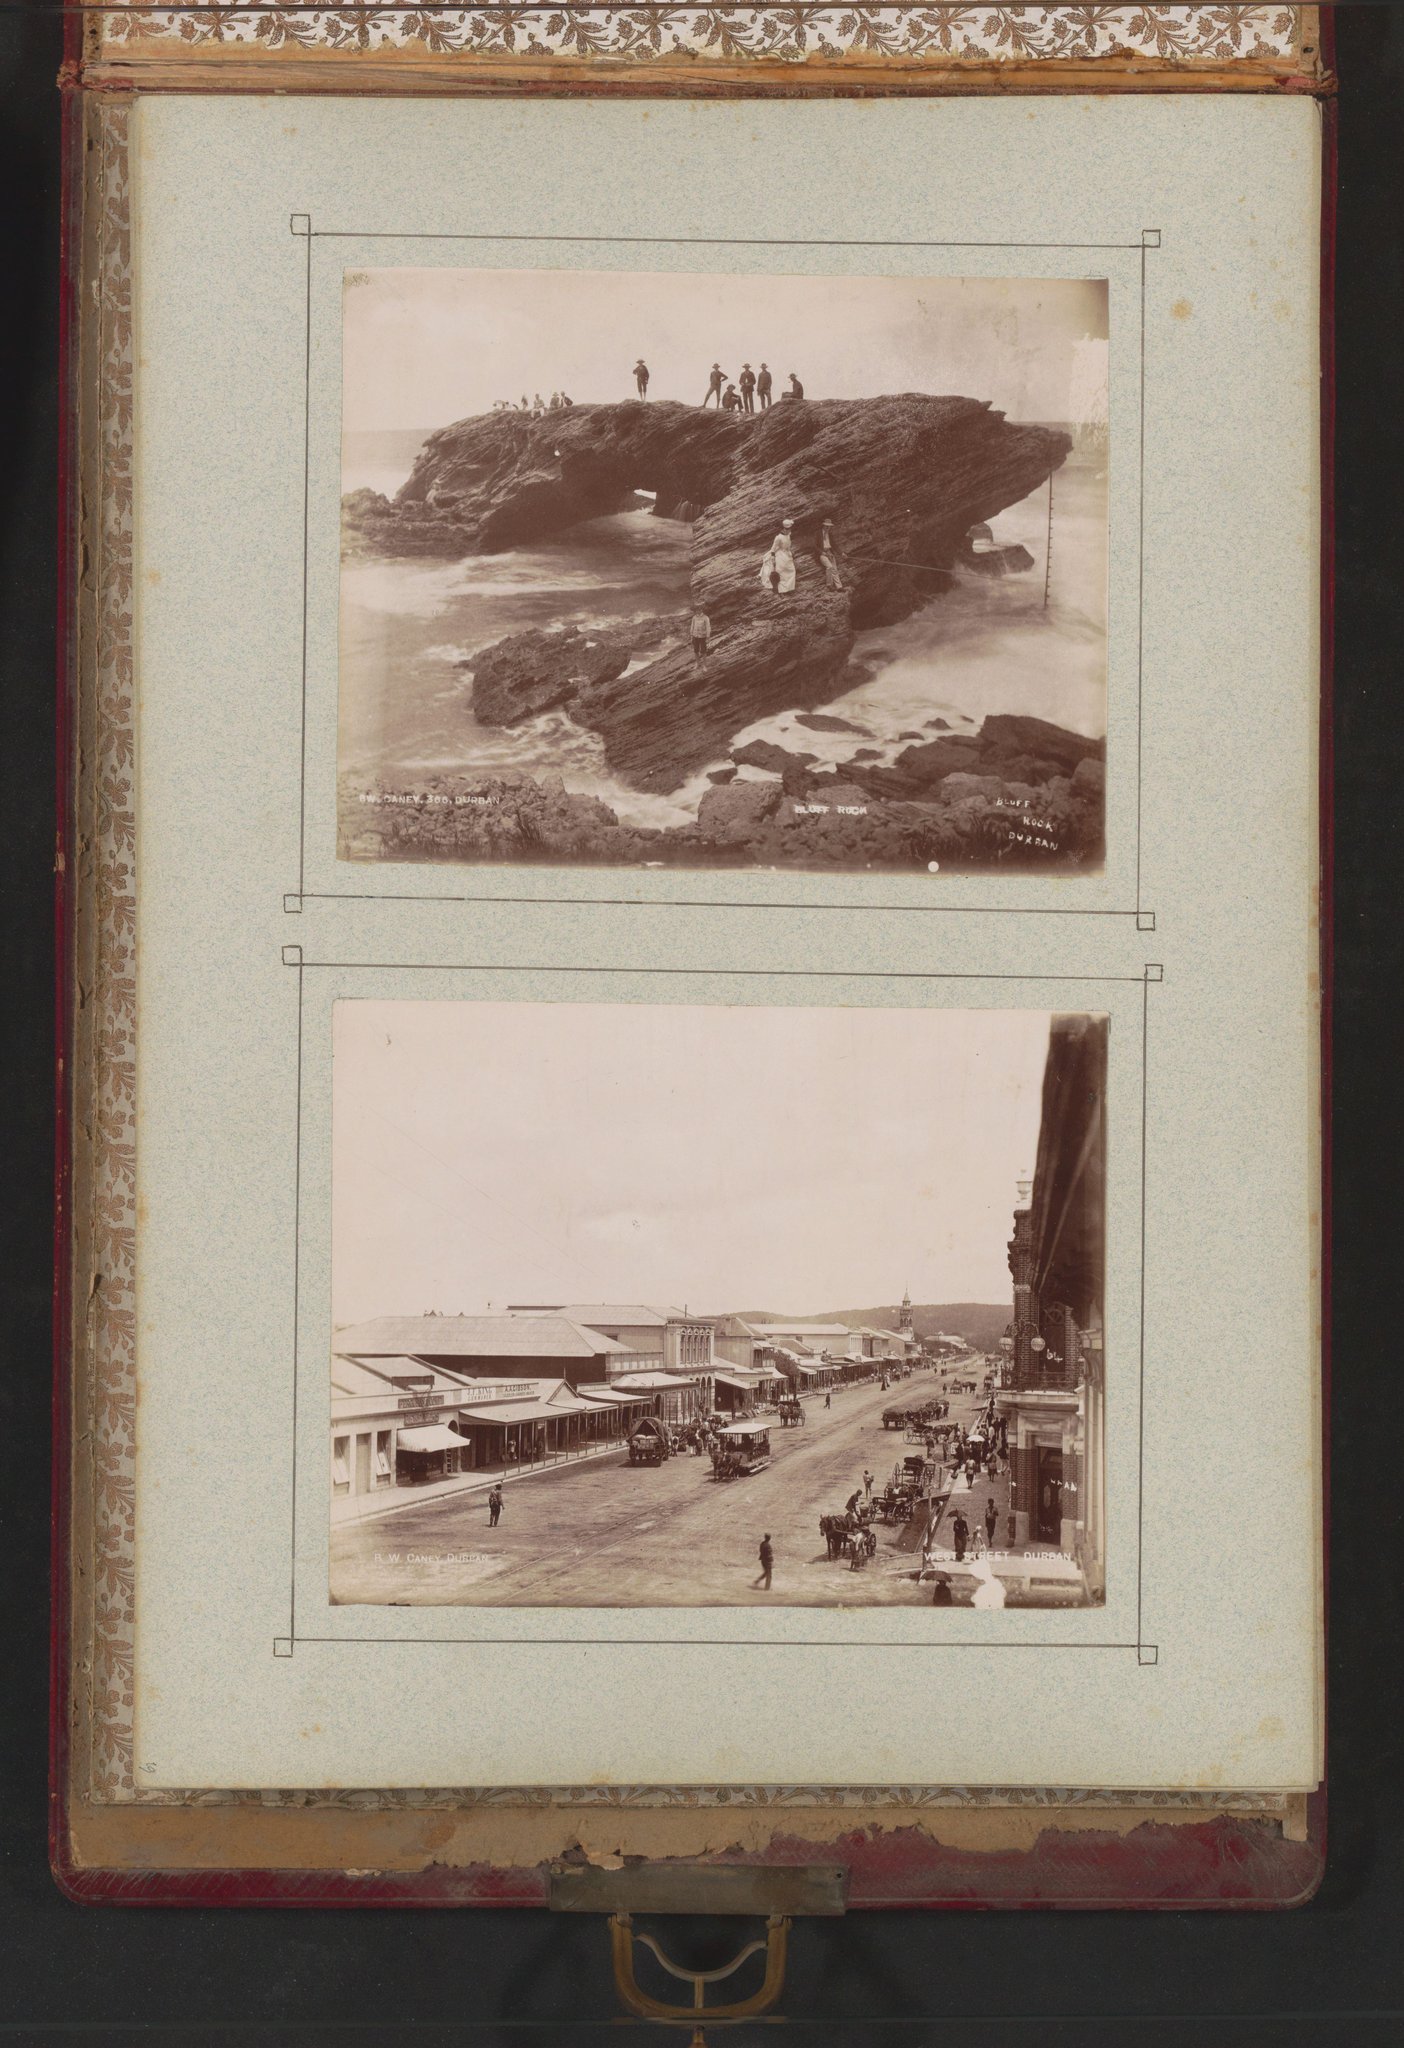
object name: photograph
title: Waterval in een kloof bij Krugersdorp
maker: henri ferdinand gros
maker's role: fotograaf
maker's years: 1842-1915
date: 1880-1900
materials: photographic support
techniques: albumen print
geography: krugersdorp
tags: waterfall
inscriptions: number: ‘438’, inscription: ‘H.F. Gros' Pictorial Description of the Transvaal. (Copyright.)’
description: Onderdeel van Reisalbum met foto's van Zuid-Afrika, Madeira, Portugal, Frankrijk en Duitsland.